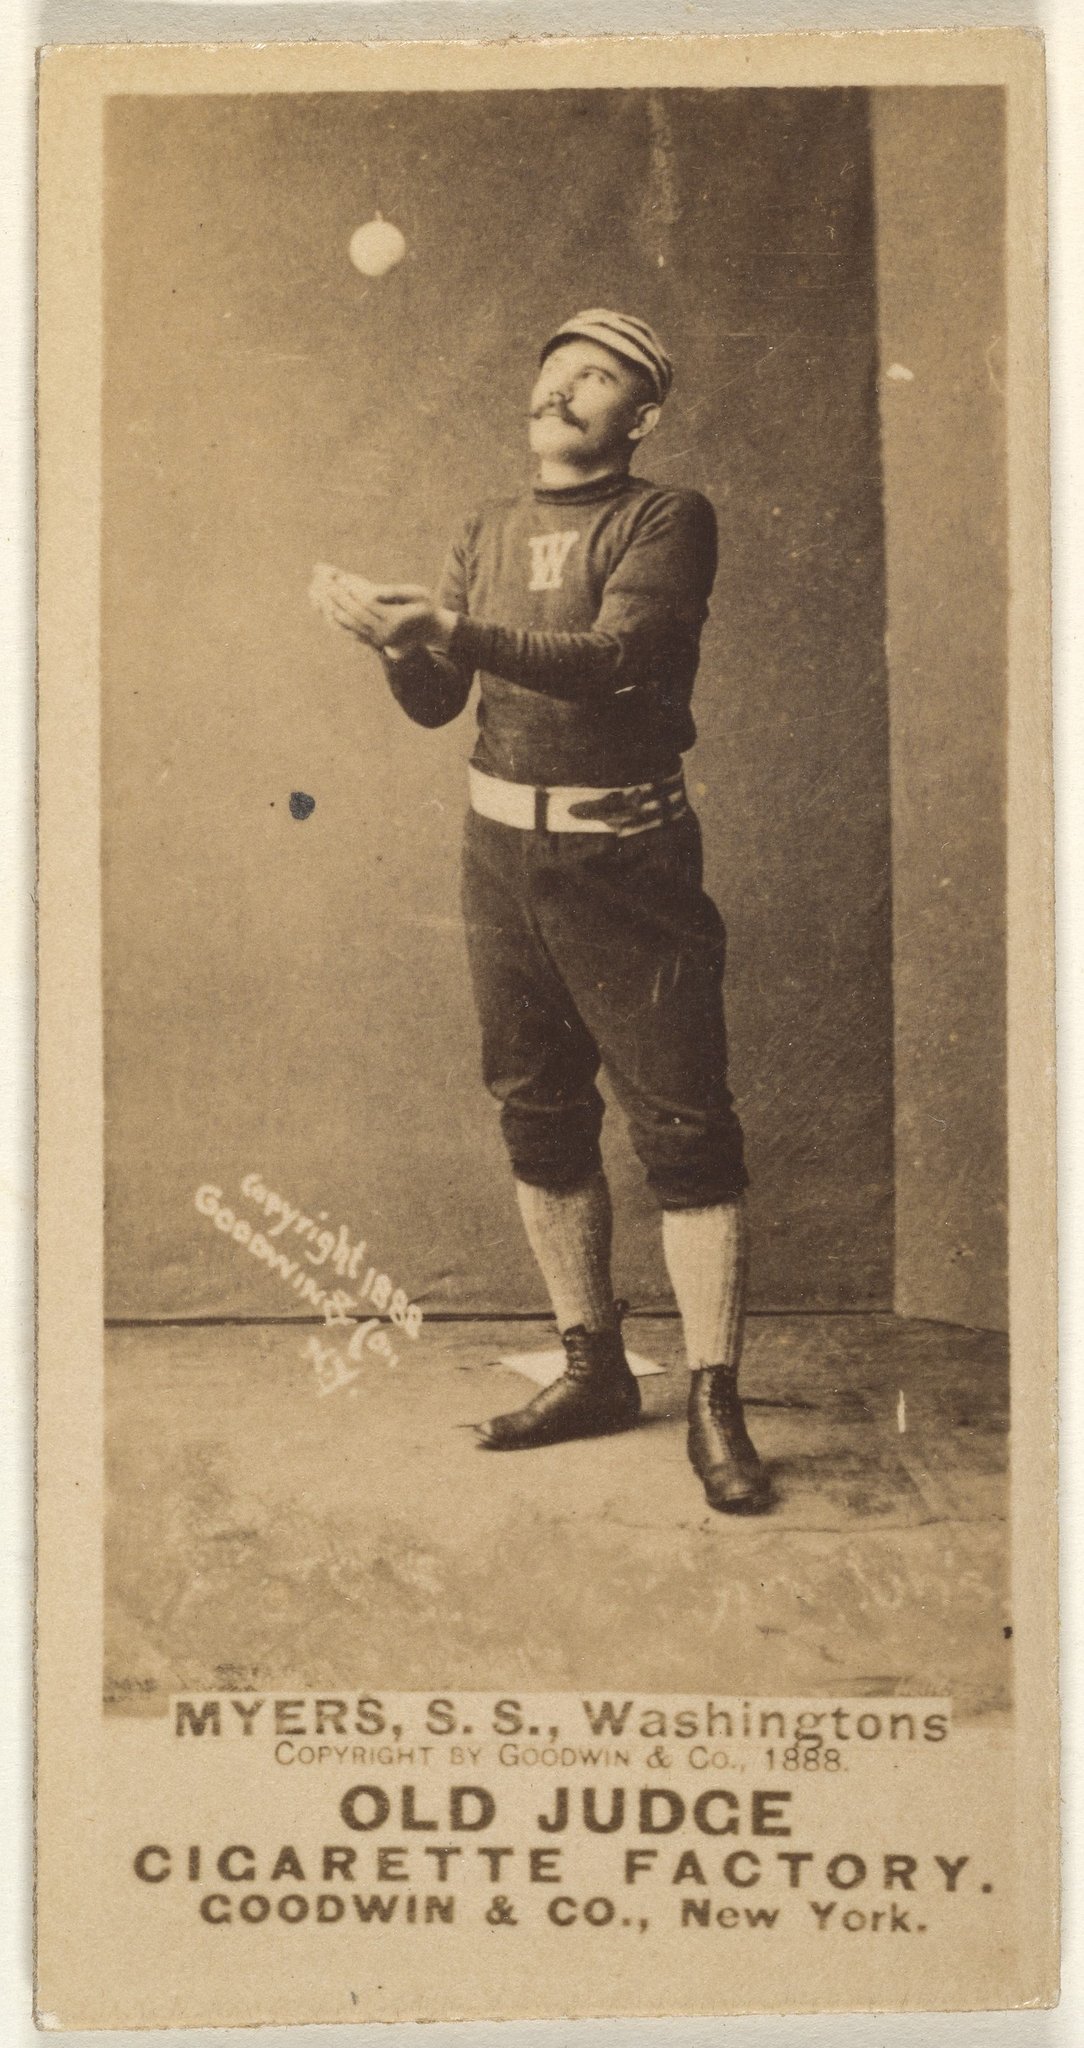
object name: baseball card, photograph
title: James Albert "Al" Myers, Shortstop, Washington Nationals, from the Old Judge series (N172) for Old Judge Cigarettes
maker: goodwin & company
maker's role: publisher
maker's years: 1850-1950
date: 1888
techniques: albumen silver print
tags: men,portraits,baseball,athletes